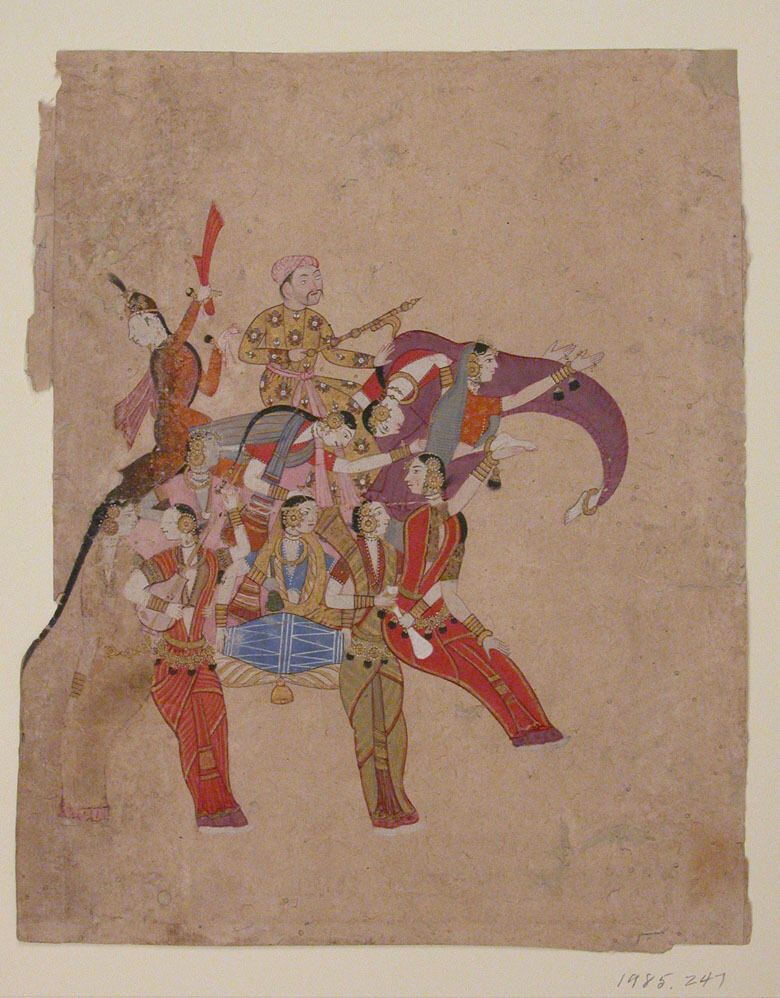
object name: illustrated single work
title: Composite Elephant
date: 1601-1633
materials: gold, ink, paper, watercolor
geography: india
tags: men,women,elephants,dancers,musicians